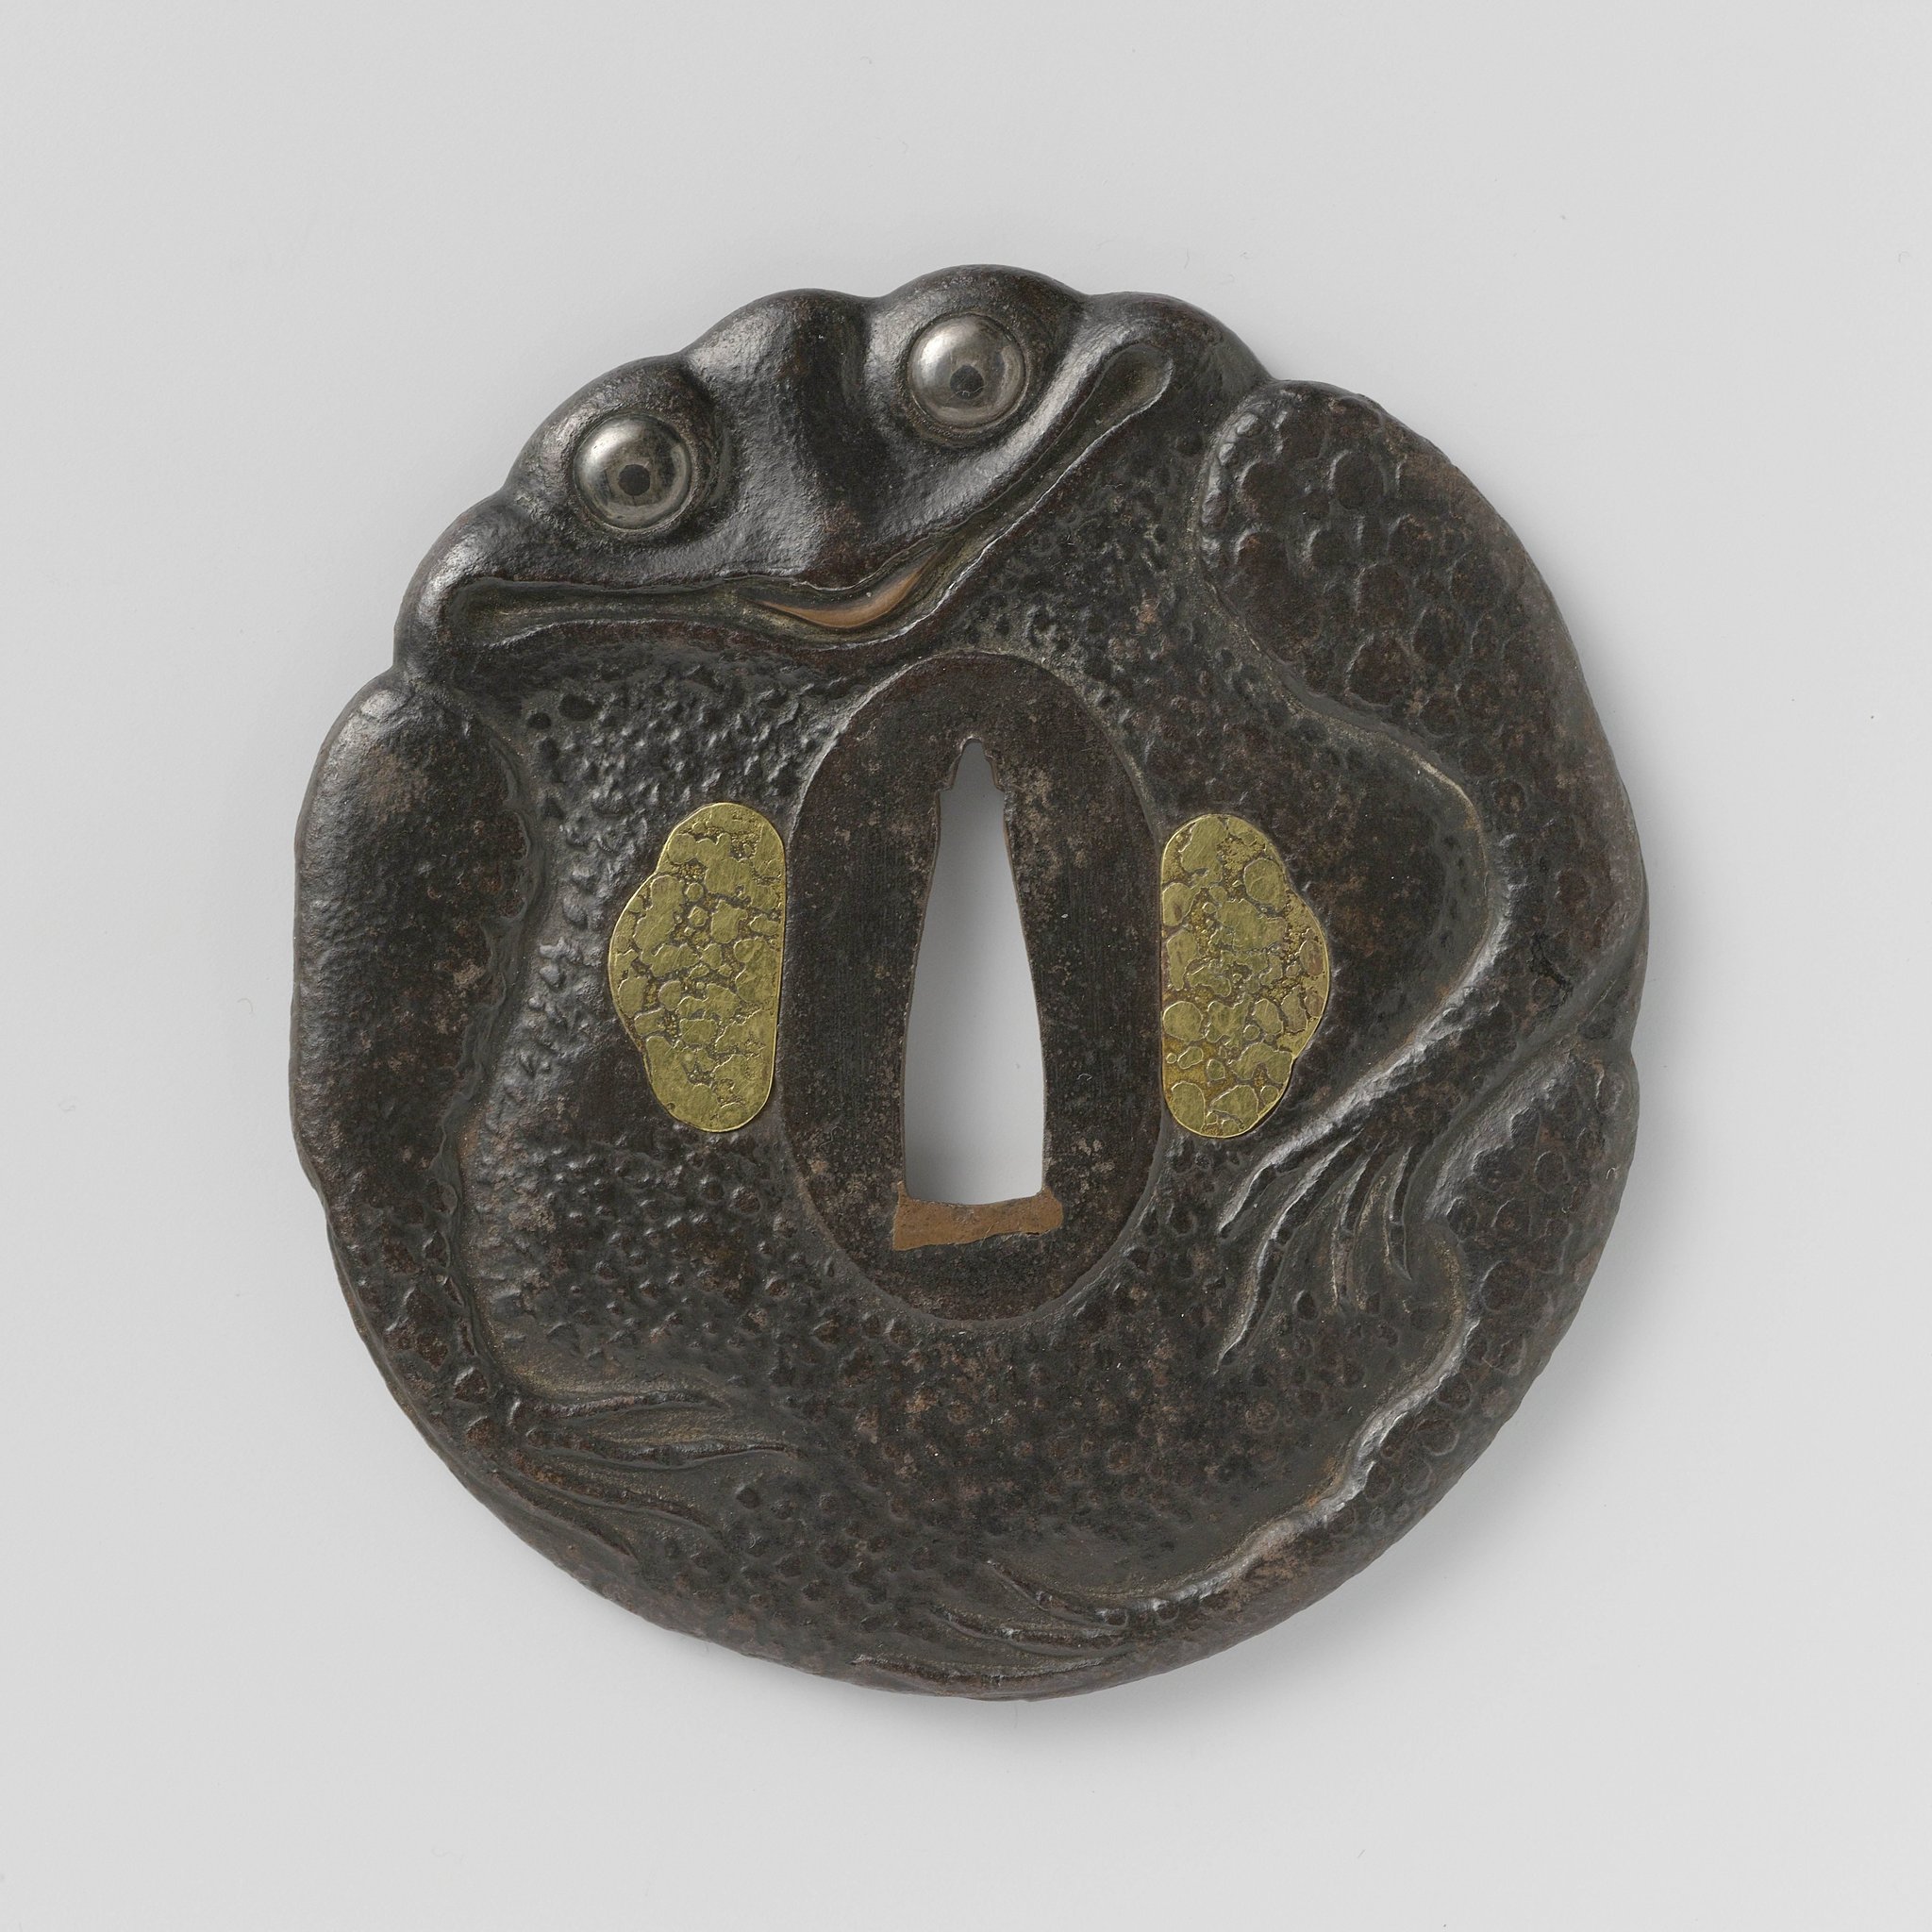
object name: tsuba, zwaardstootplaat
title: Hand guard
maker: Anonymous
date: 1600-1900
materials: copper, gold, iron, silver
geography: japan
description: Ovale tsuba in de vorm van een kikker met zilveren ogen en een koperen tong; de ryo- hitsu zijn opgevuld met goud, dat bewerkt is als het ijzer (ishime-oppervlak).